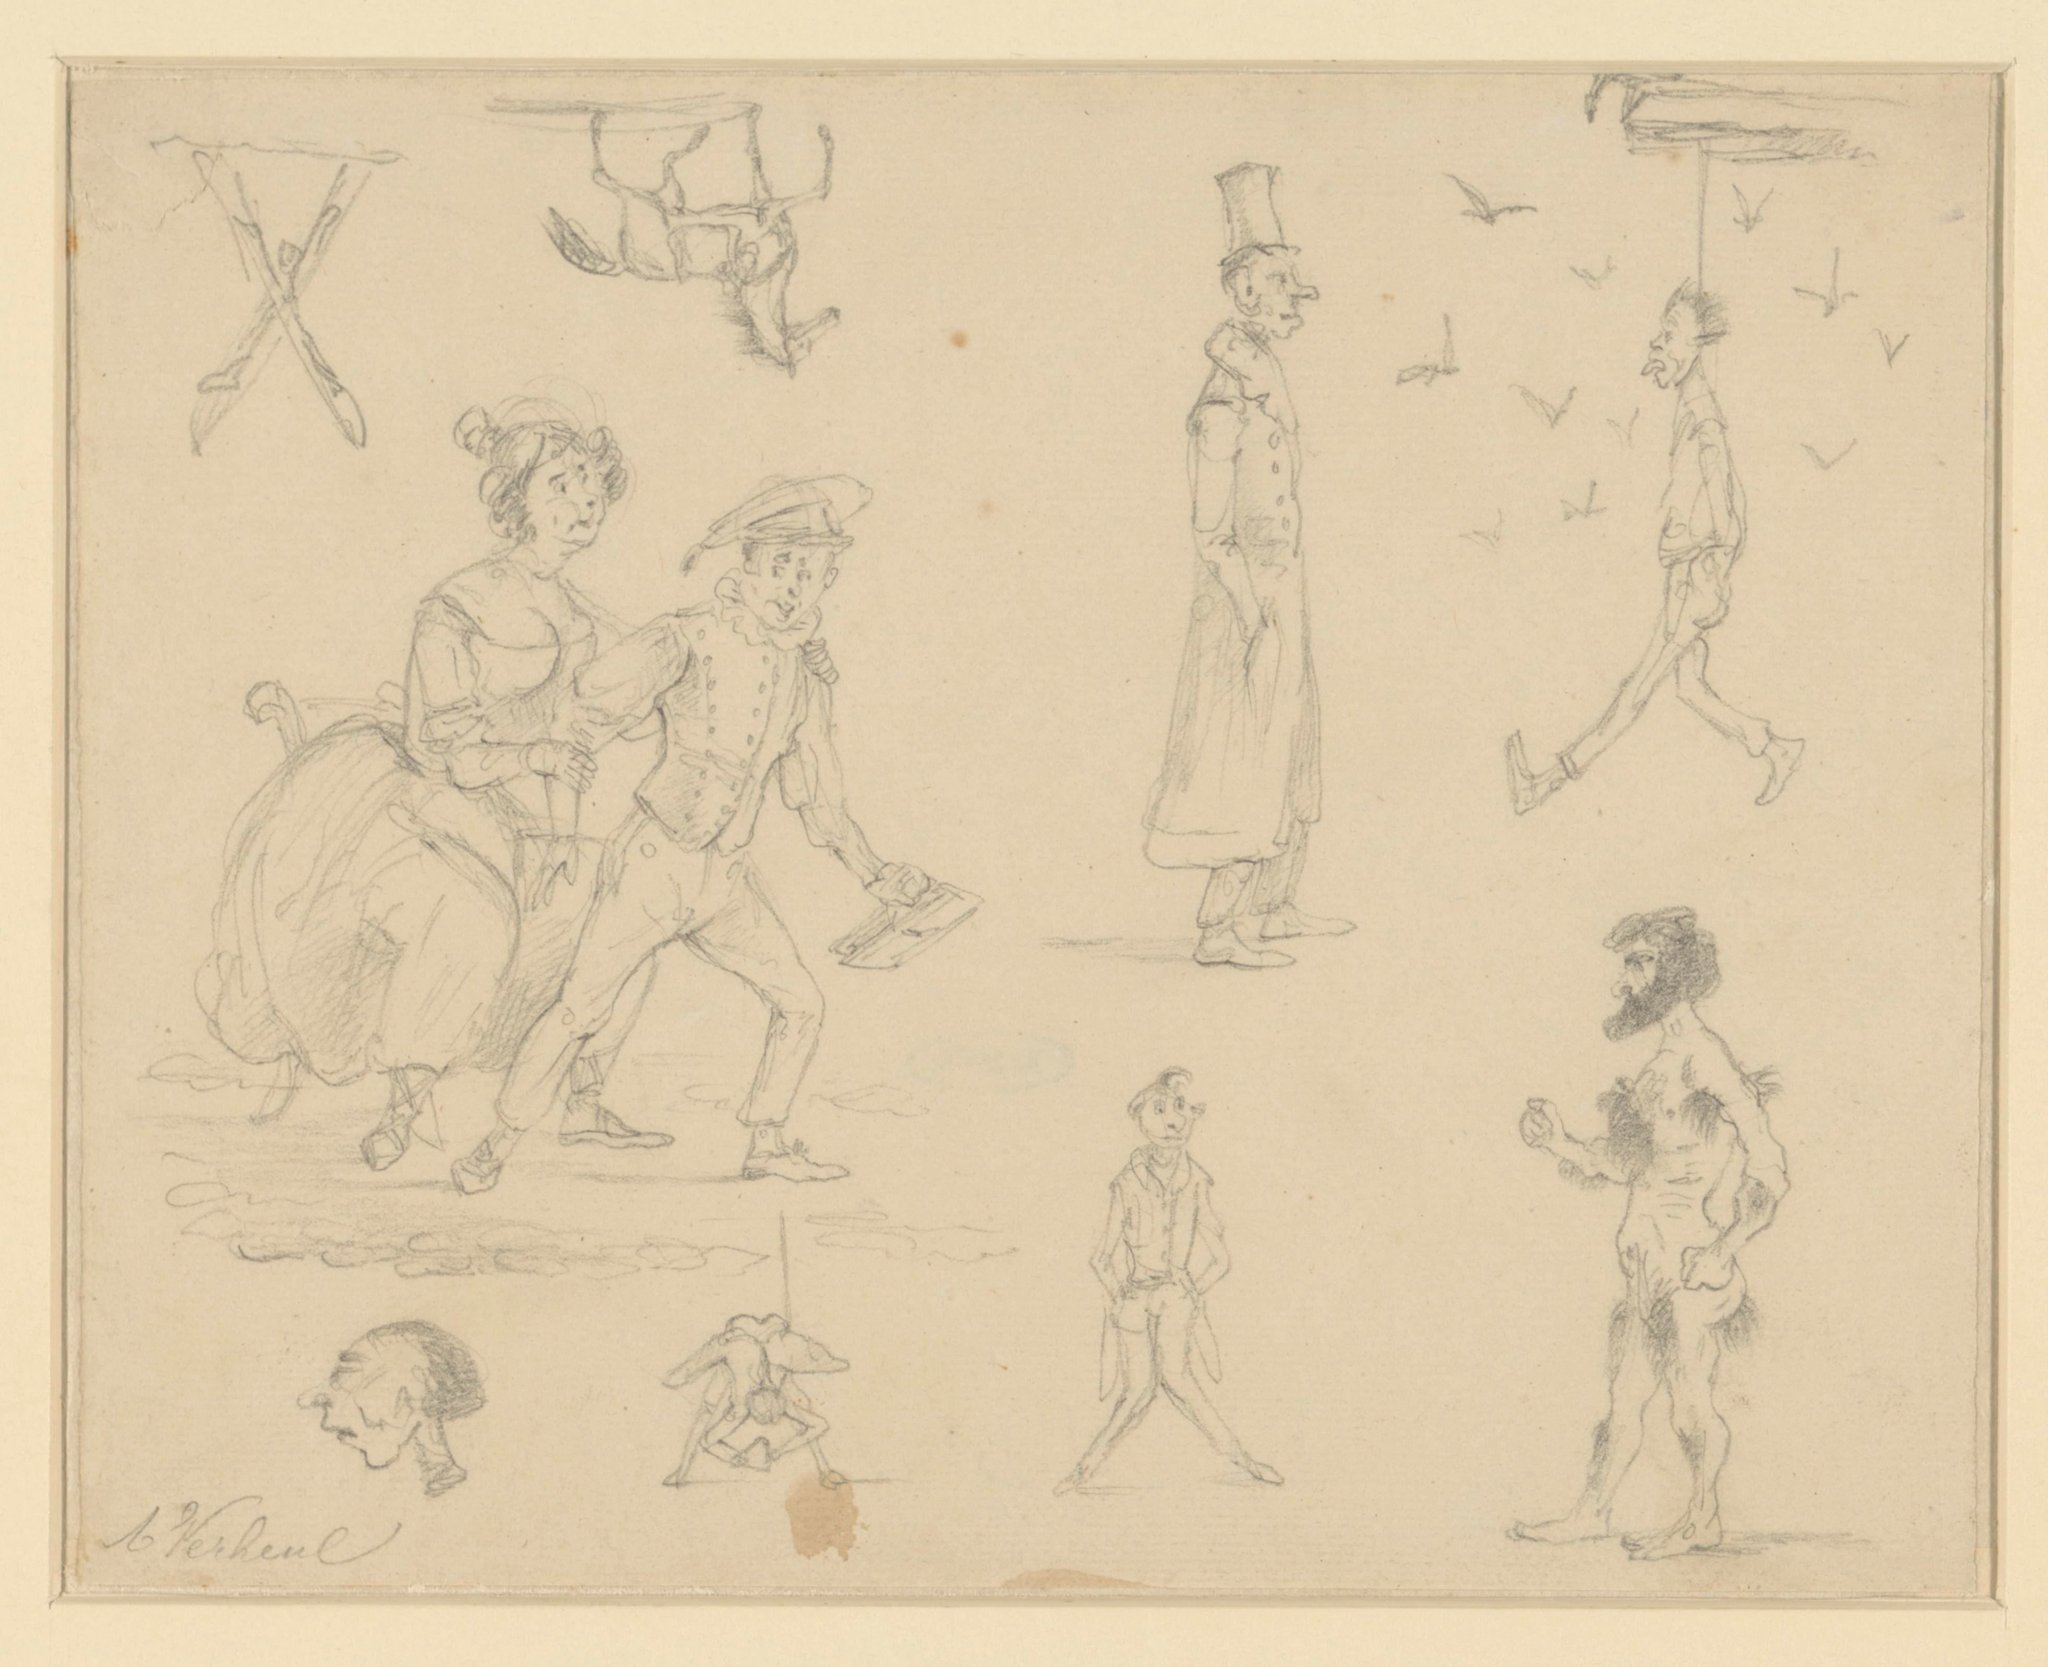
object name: drawing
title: Schetsen van verschillende figuren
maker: alexander ver huell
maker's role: draughtsman, print maker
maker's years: 1822-1897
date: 1832-1897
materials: paper, pencil